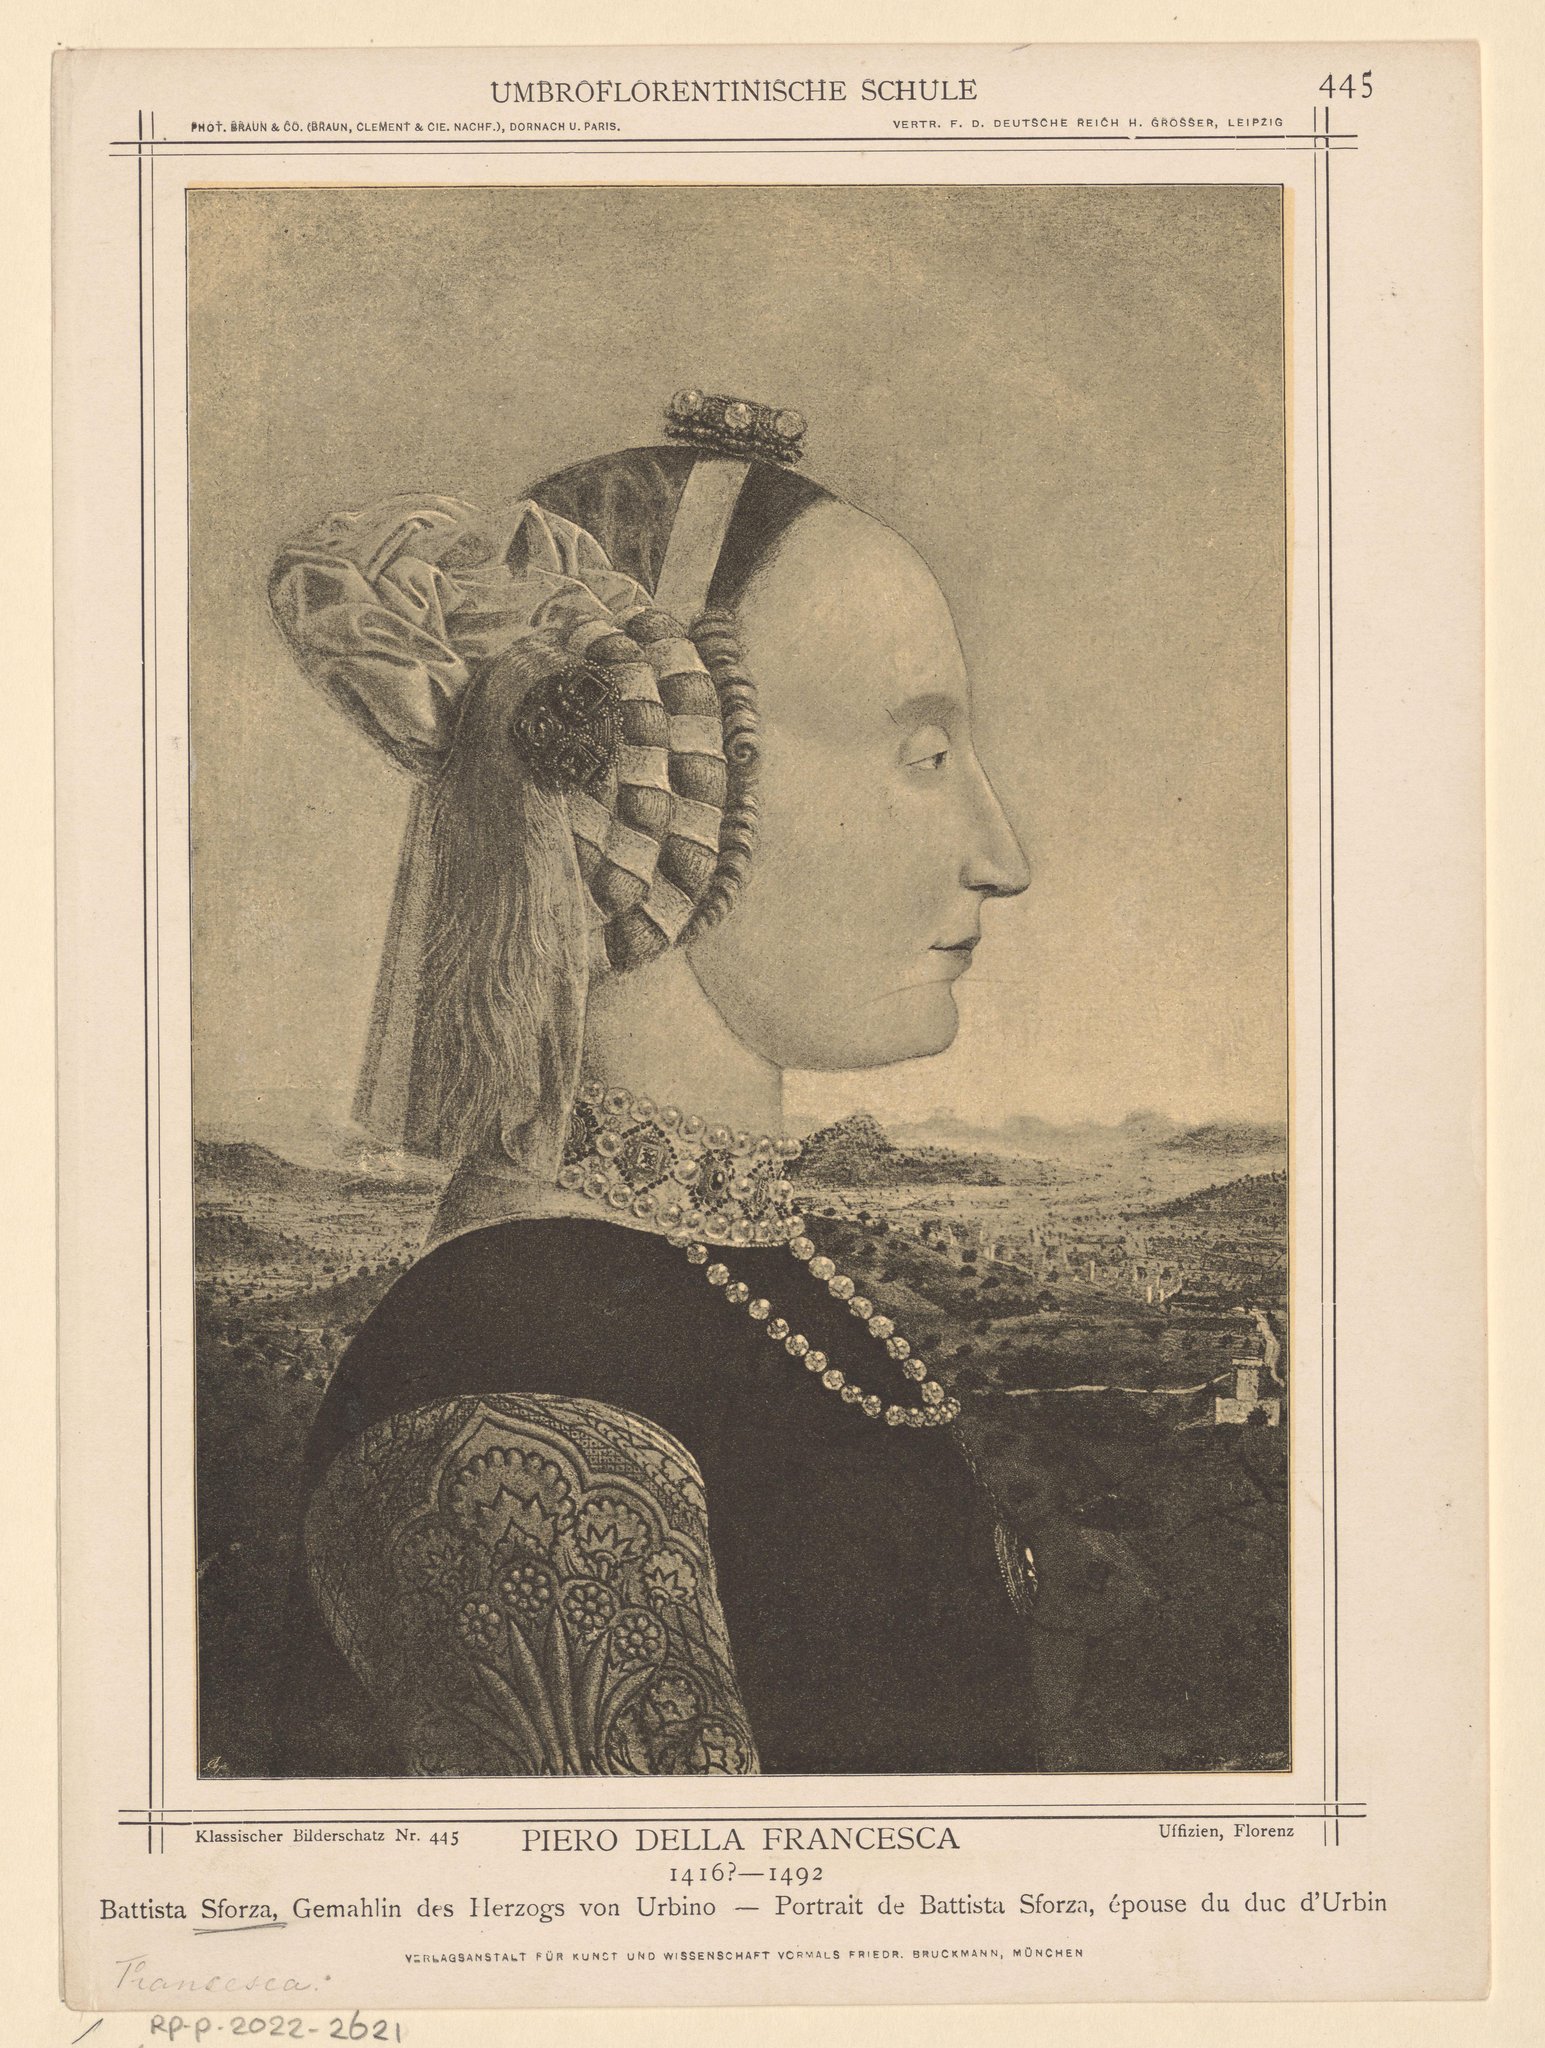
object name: photomechanical print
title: Portret van Battista Sforza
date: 1892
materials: paper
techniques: autotype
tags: historical persons - bb - woman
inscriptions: collector's mark: Lugt 2228, name: ‘Francesca’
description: Fotomechanische afdruk uit: Reber, Franz von. Klassischer Bilderschatz. München: Verlagsanstalt für Kunst und Wissenschaft, 1892, dl. 4.